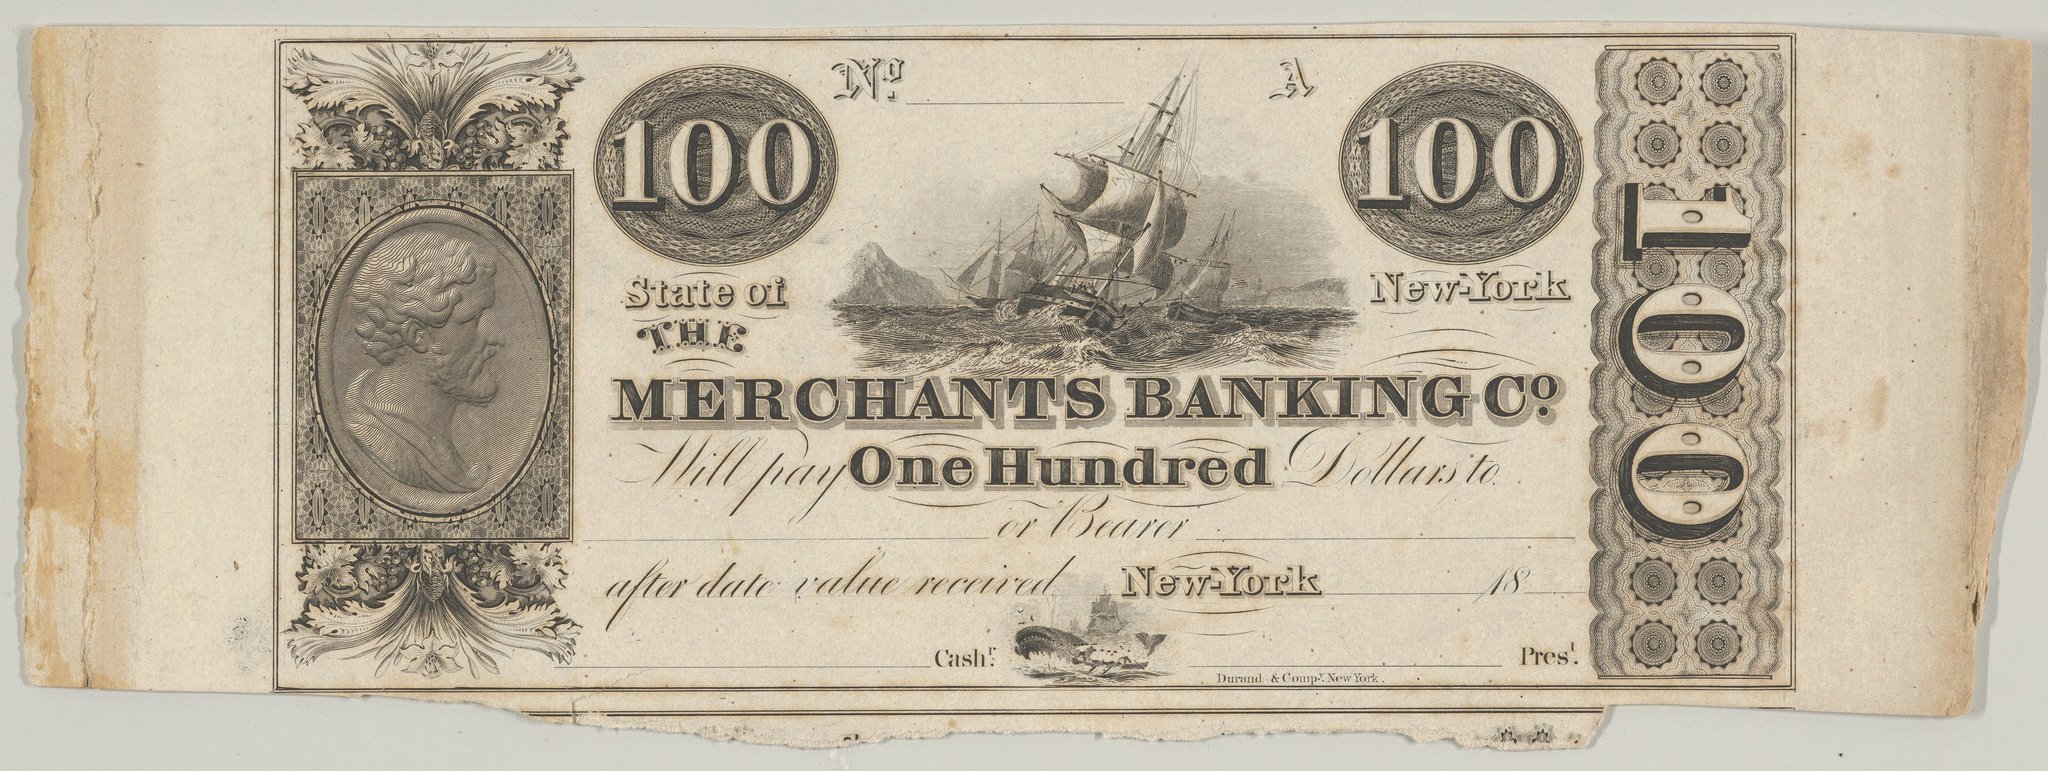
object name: print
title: Proof of one side of a New York Merchants Banking Company 100 Dollar Bill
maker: asher brown durand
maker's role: artist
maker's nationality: american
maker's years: 1796-1886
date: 1824-1827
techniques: engraving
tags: money